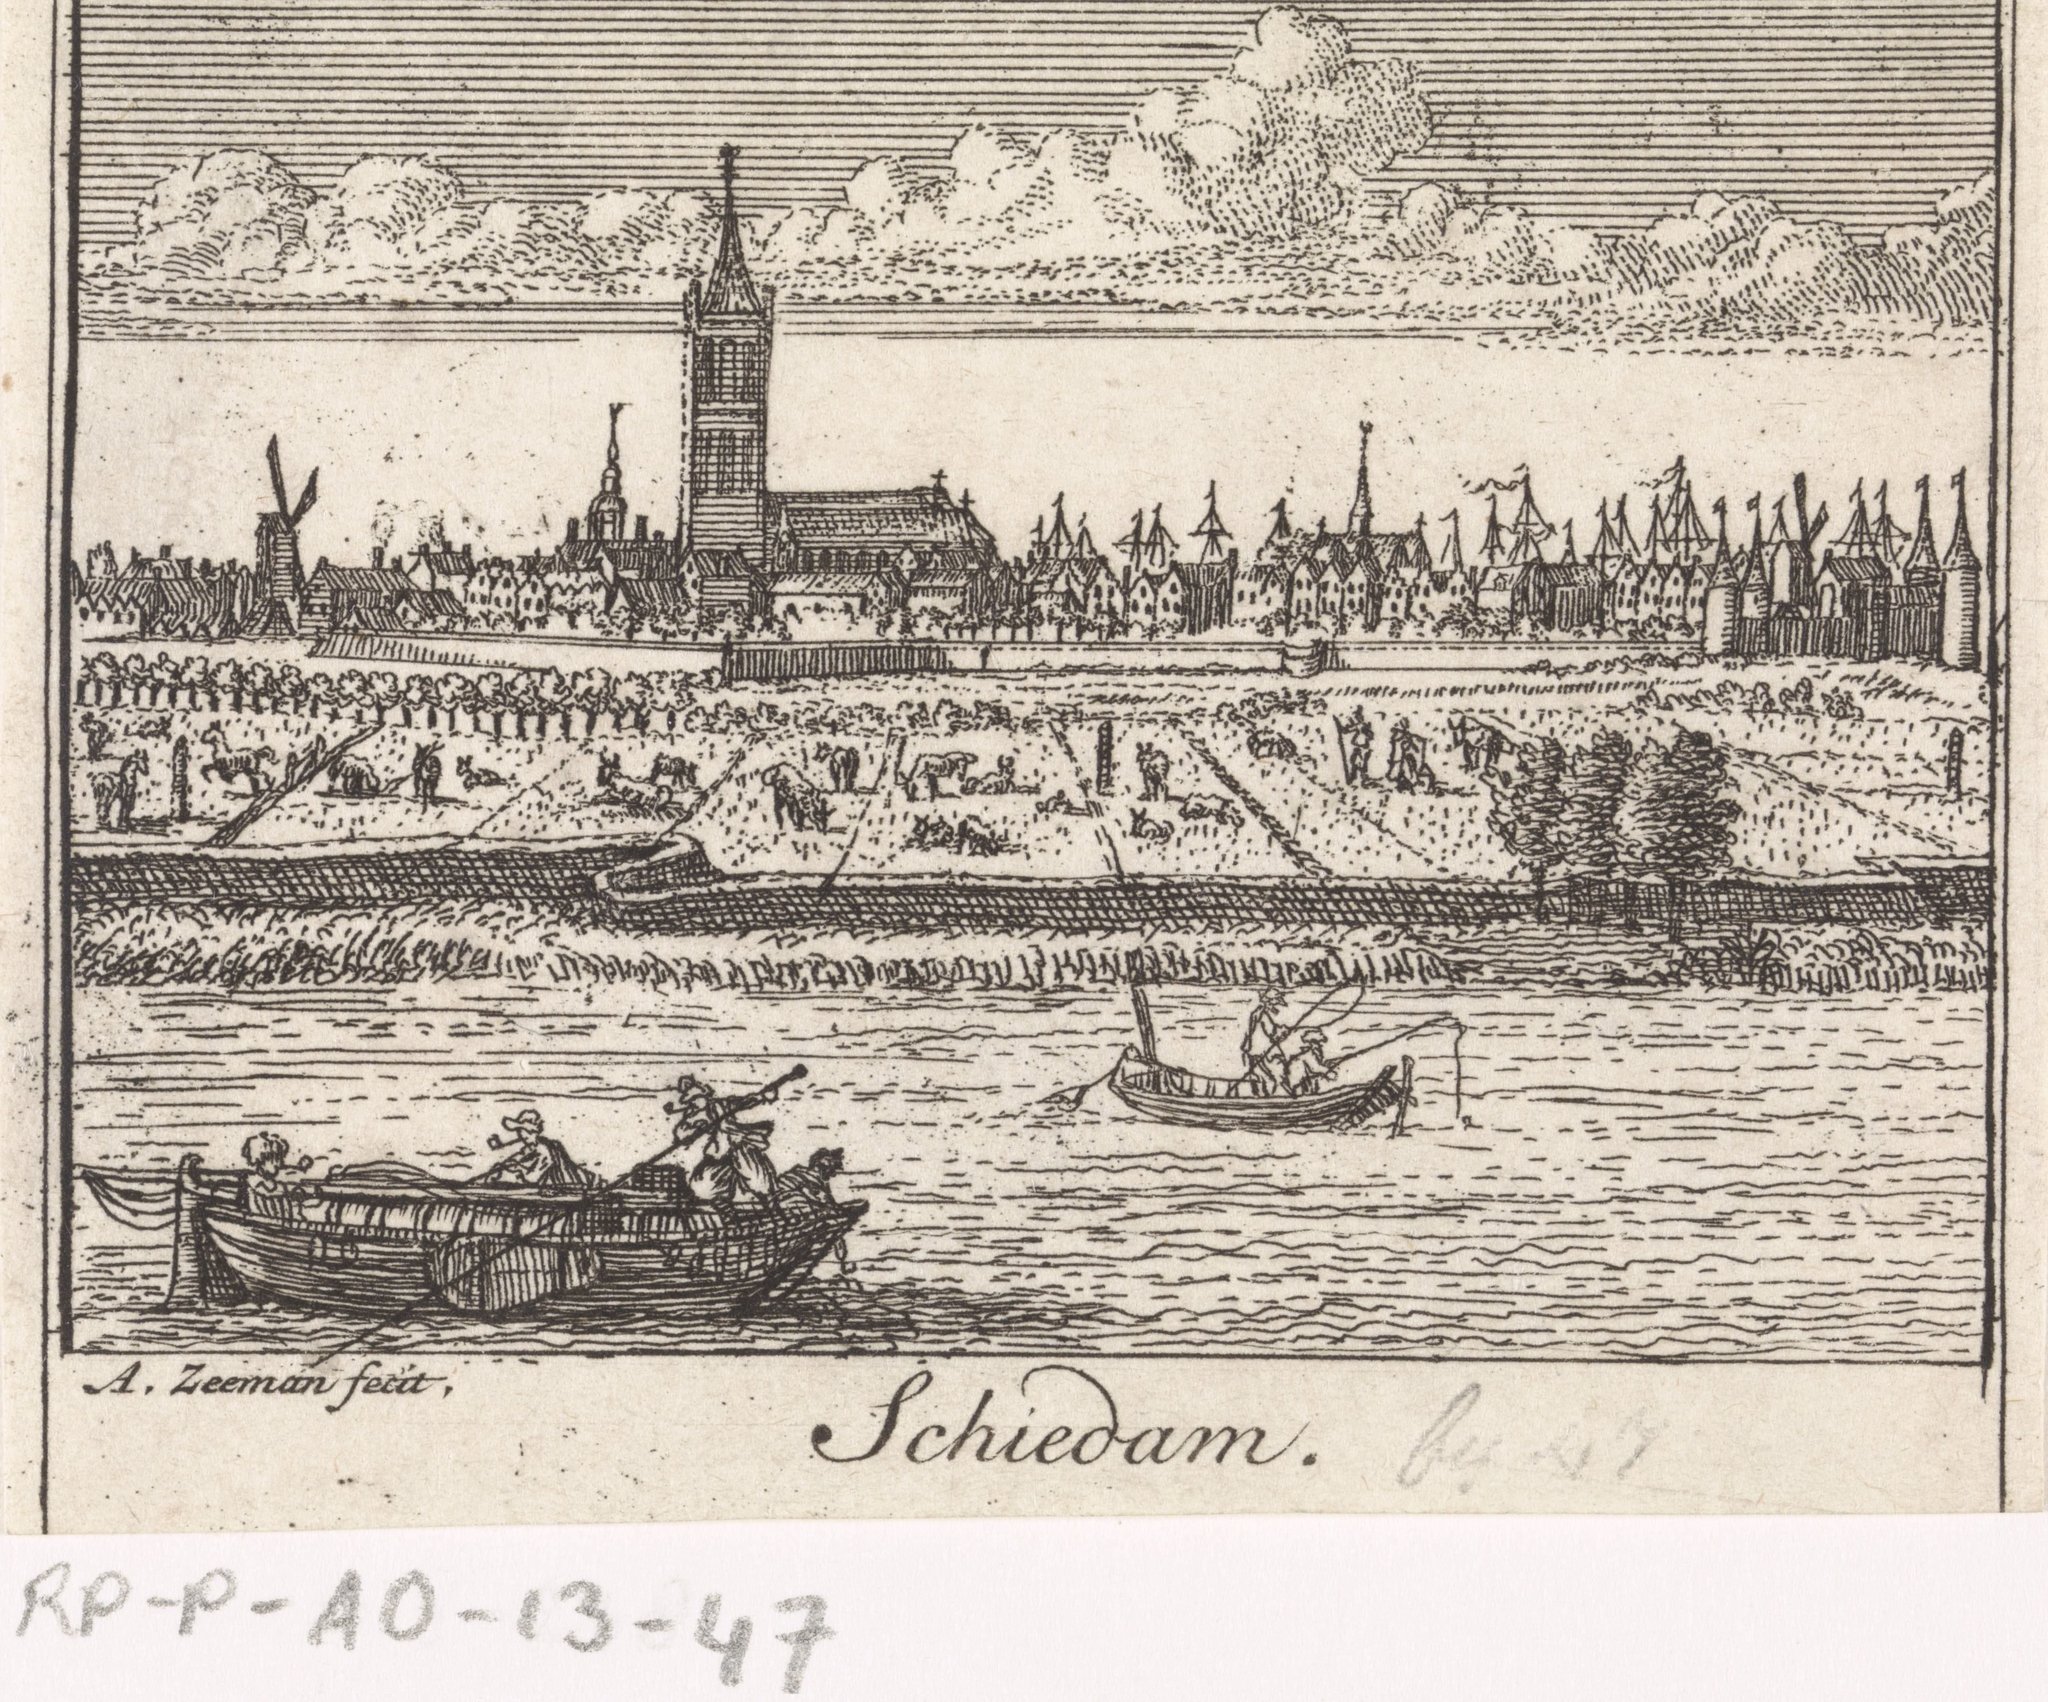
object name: book illustration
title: Gezicht op Schiedam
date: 1730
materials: paper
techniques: etching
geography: middelburg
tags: city-view in general; 'veduta'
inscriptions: collector's mark: Lugt 2228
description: Prent uit: Bruin, Claas. Kleefsche en Zuid-Hollandsche Arkadia, of Dag-verhaal van twee reizen, in en omtrent die gewesten gedaan. Amsterdam: Evert Visscher, 1730, na p. 158.